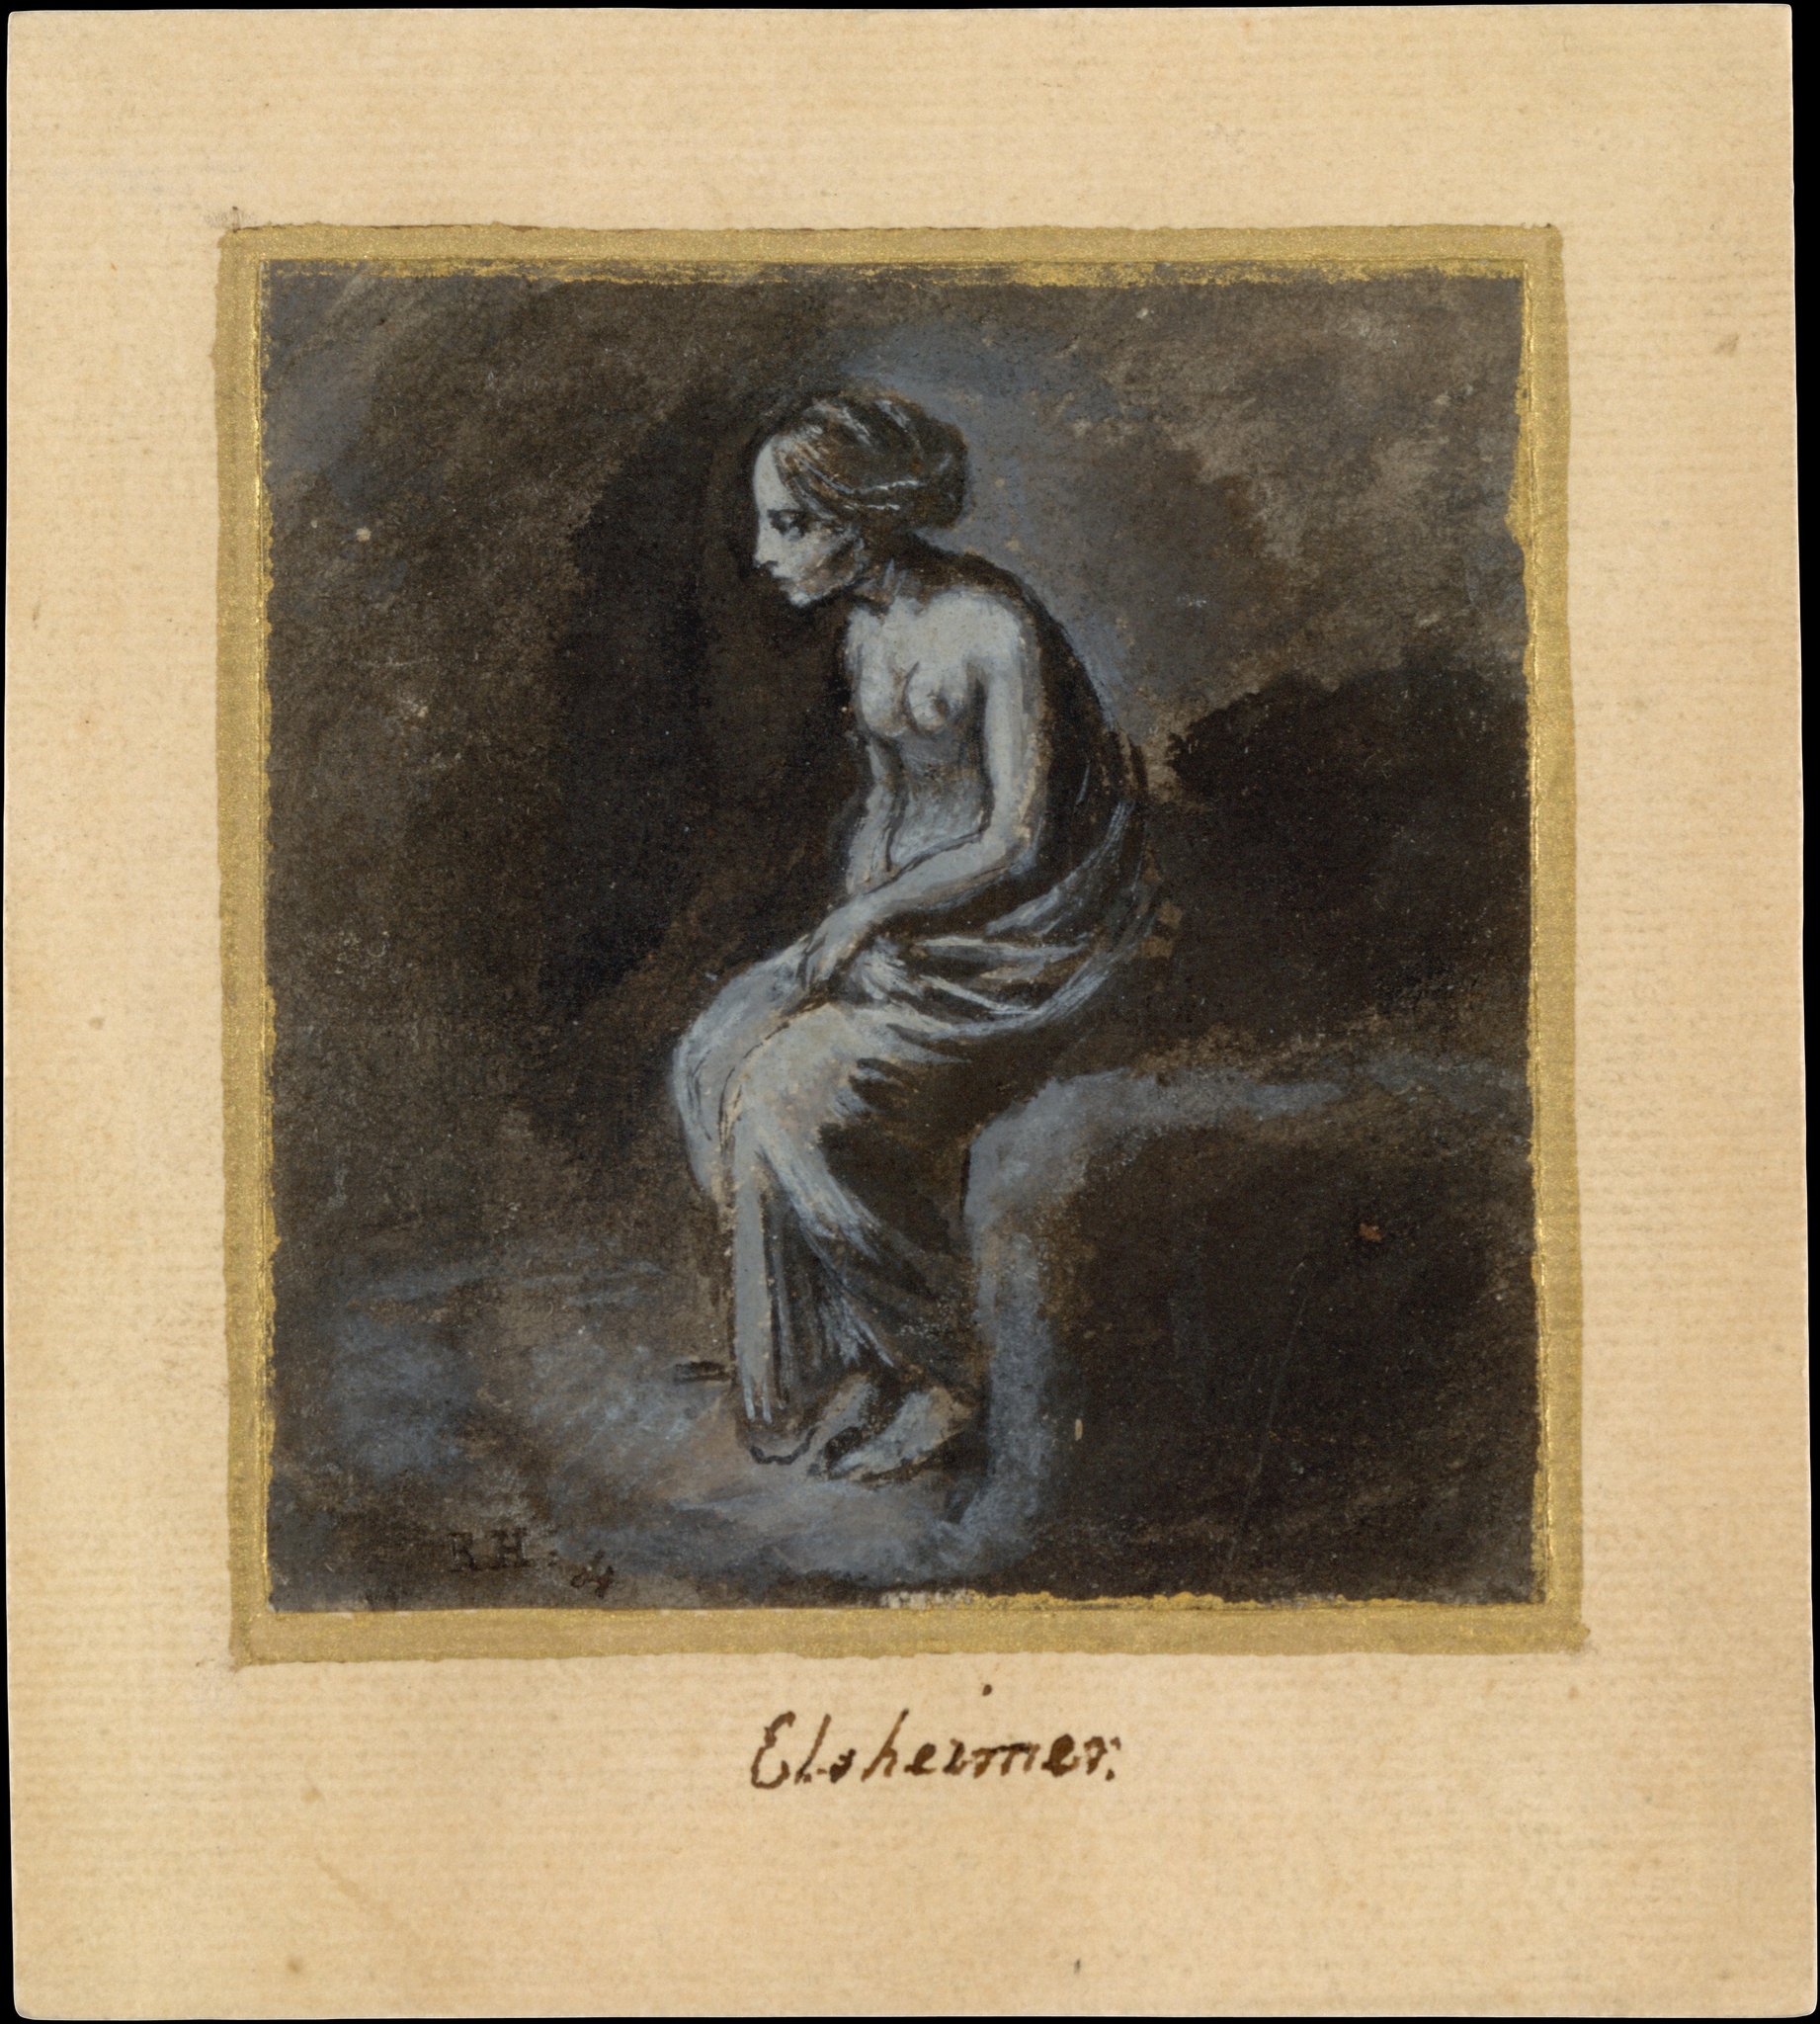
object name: drawing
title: Seated Young Woman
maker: adam elsheimer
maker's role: artist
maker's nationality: german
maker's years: 1578-1610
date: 1567-1633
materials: gouache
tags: women